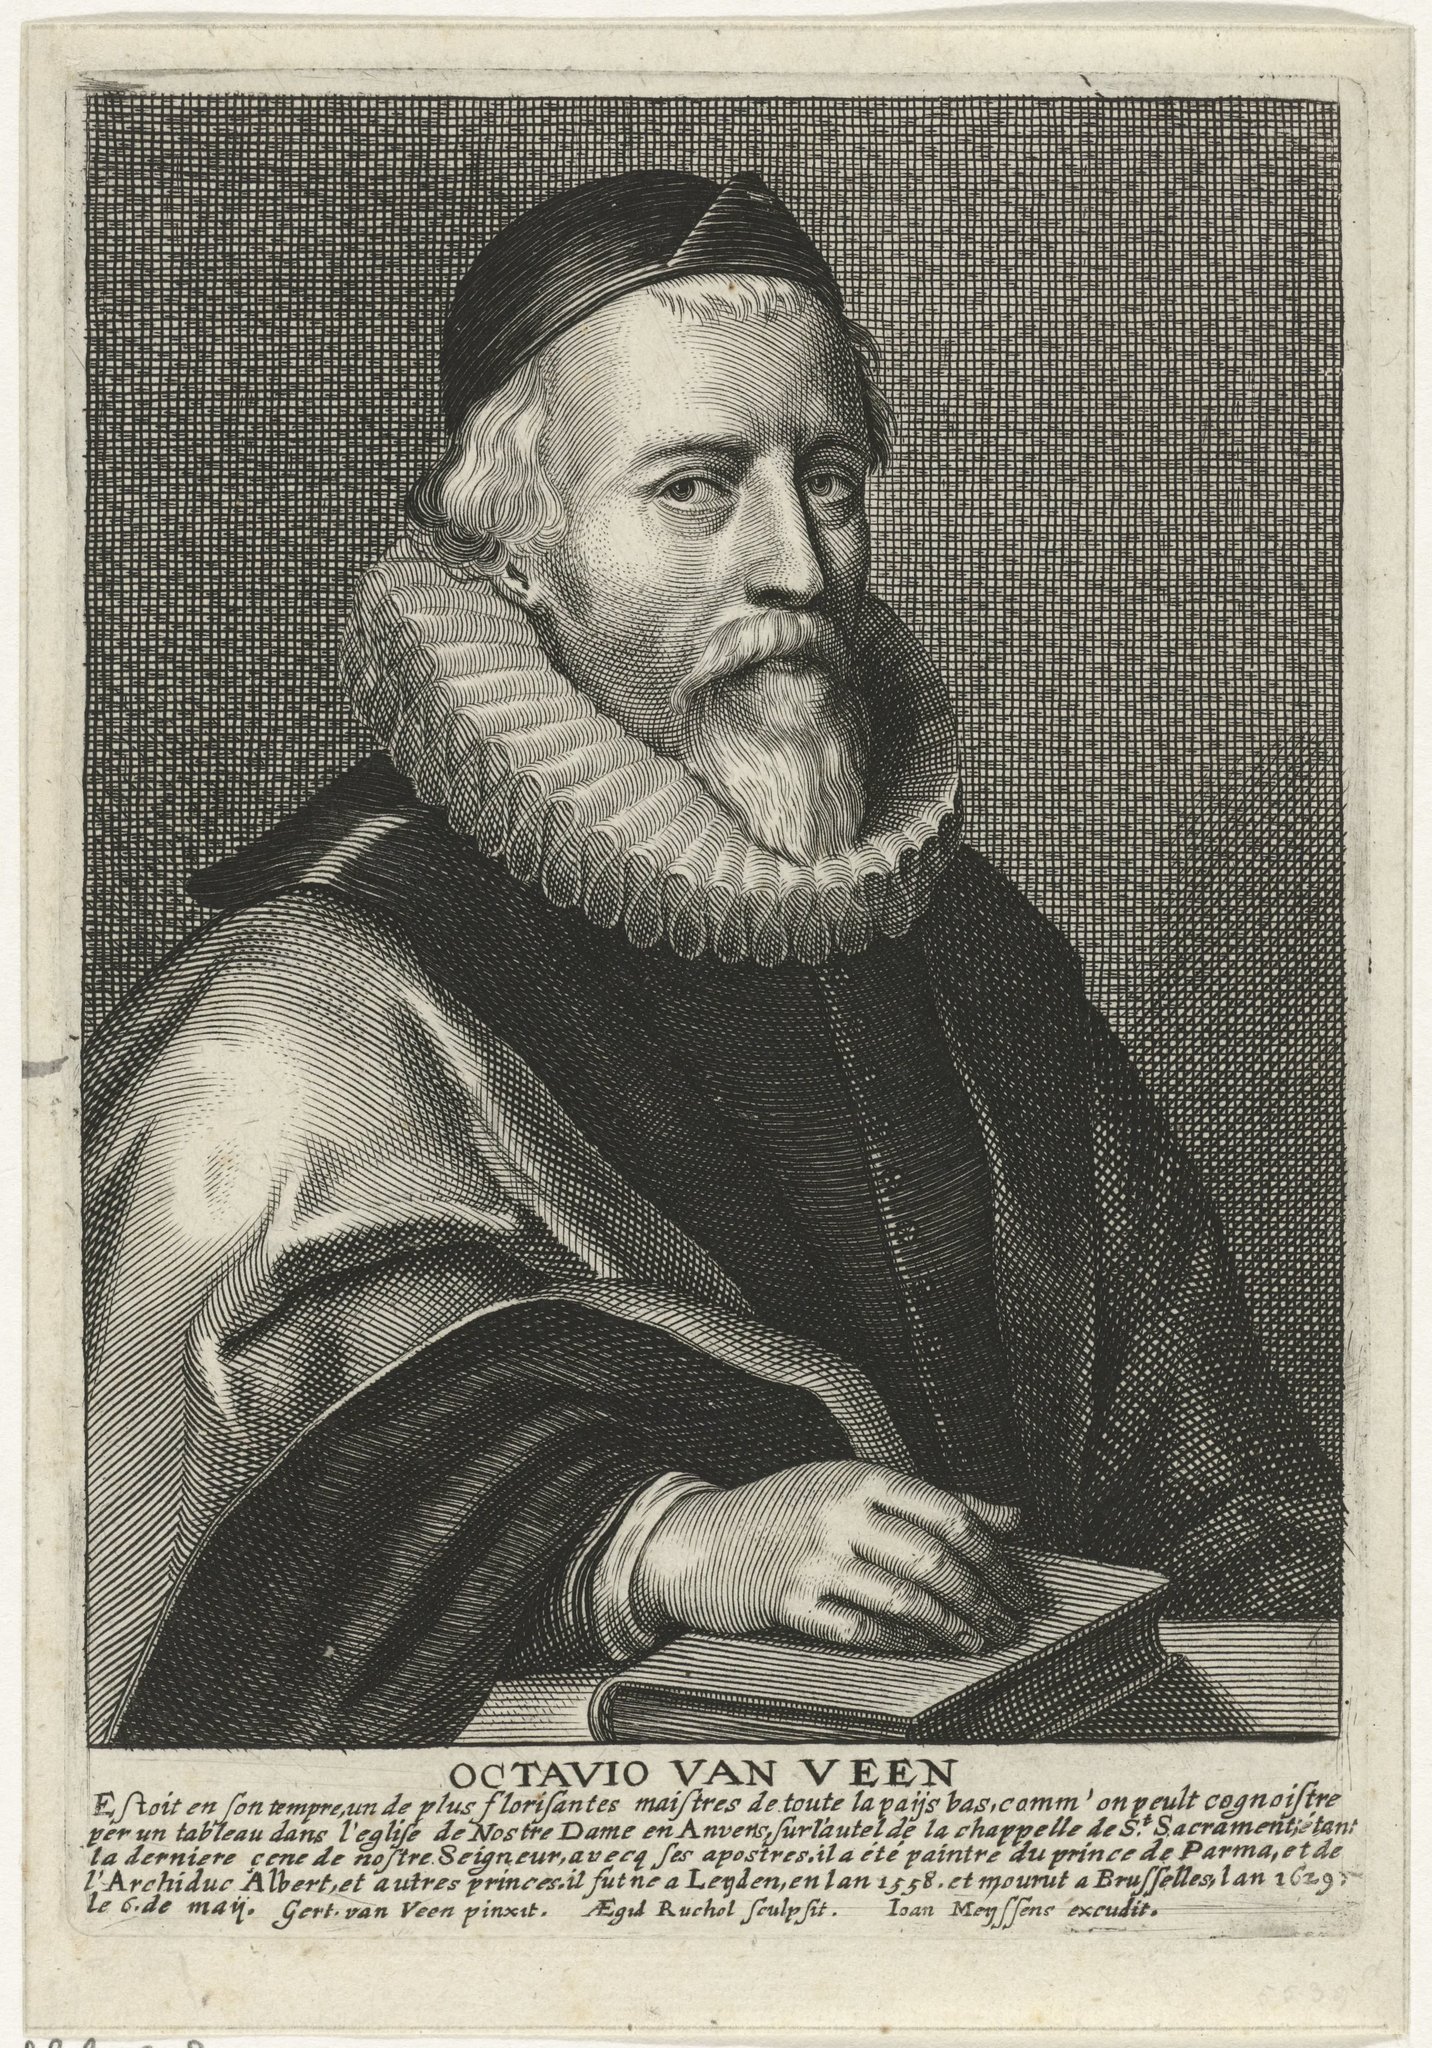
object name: print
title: Portret van Otto van Veen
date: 1644-1661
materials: paper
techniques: engraving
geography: antwerp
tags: leiden, brussels, painter, draughtsman, otto van veen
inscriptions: collector's mark: Lugt 2228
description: Portret van de kunstschilder Otto van Veen. In de marge een vijfregelige tekst in het Frans.